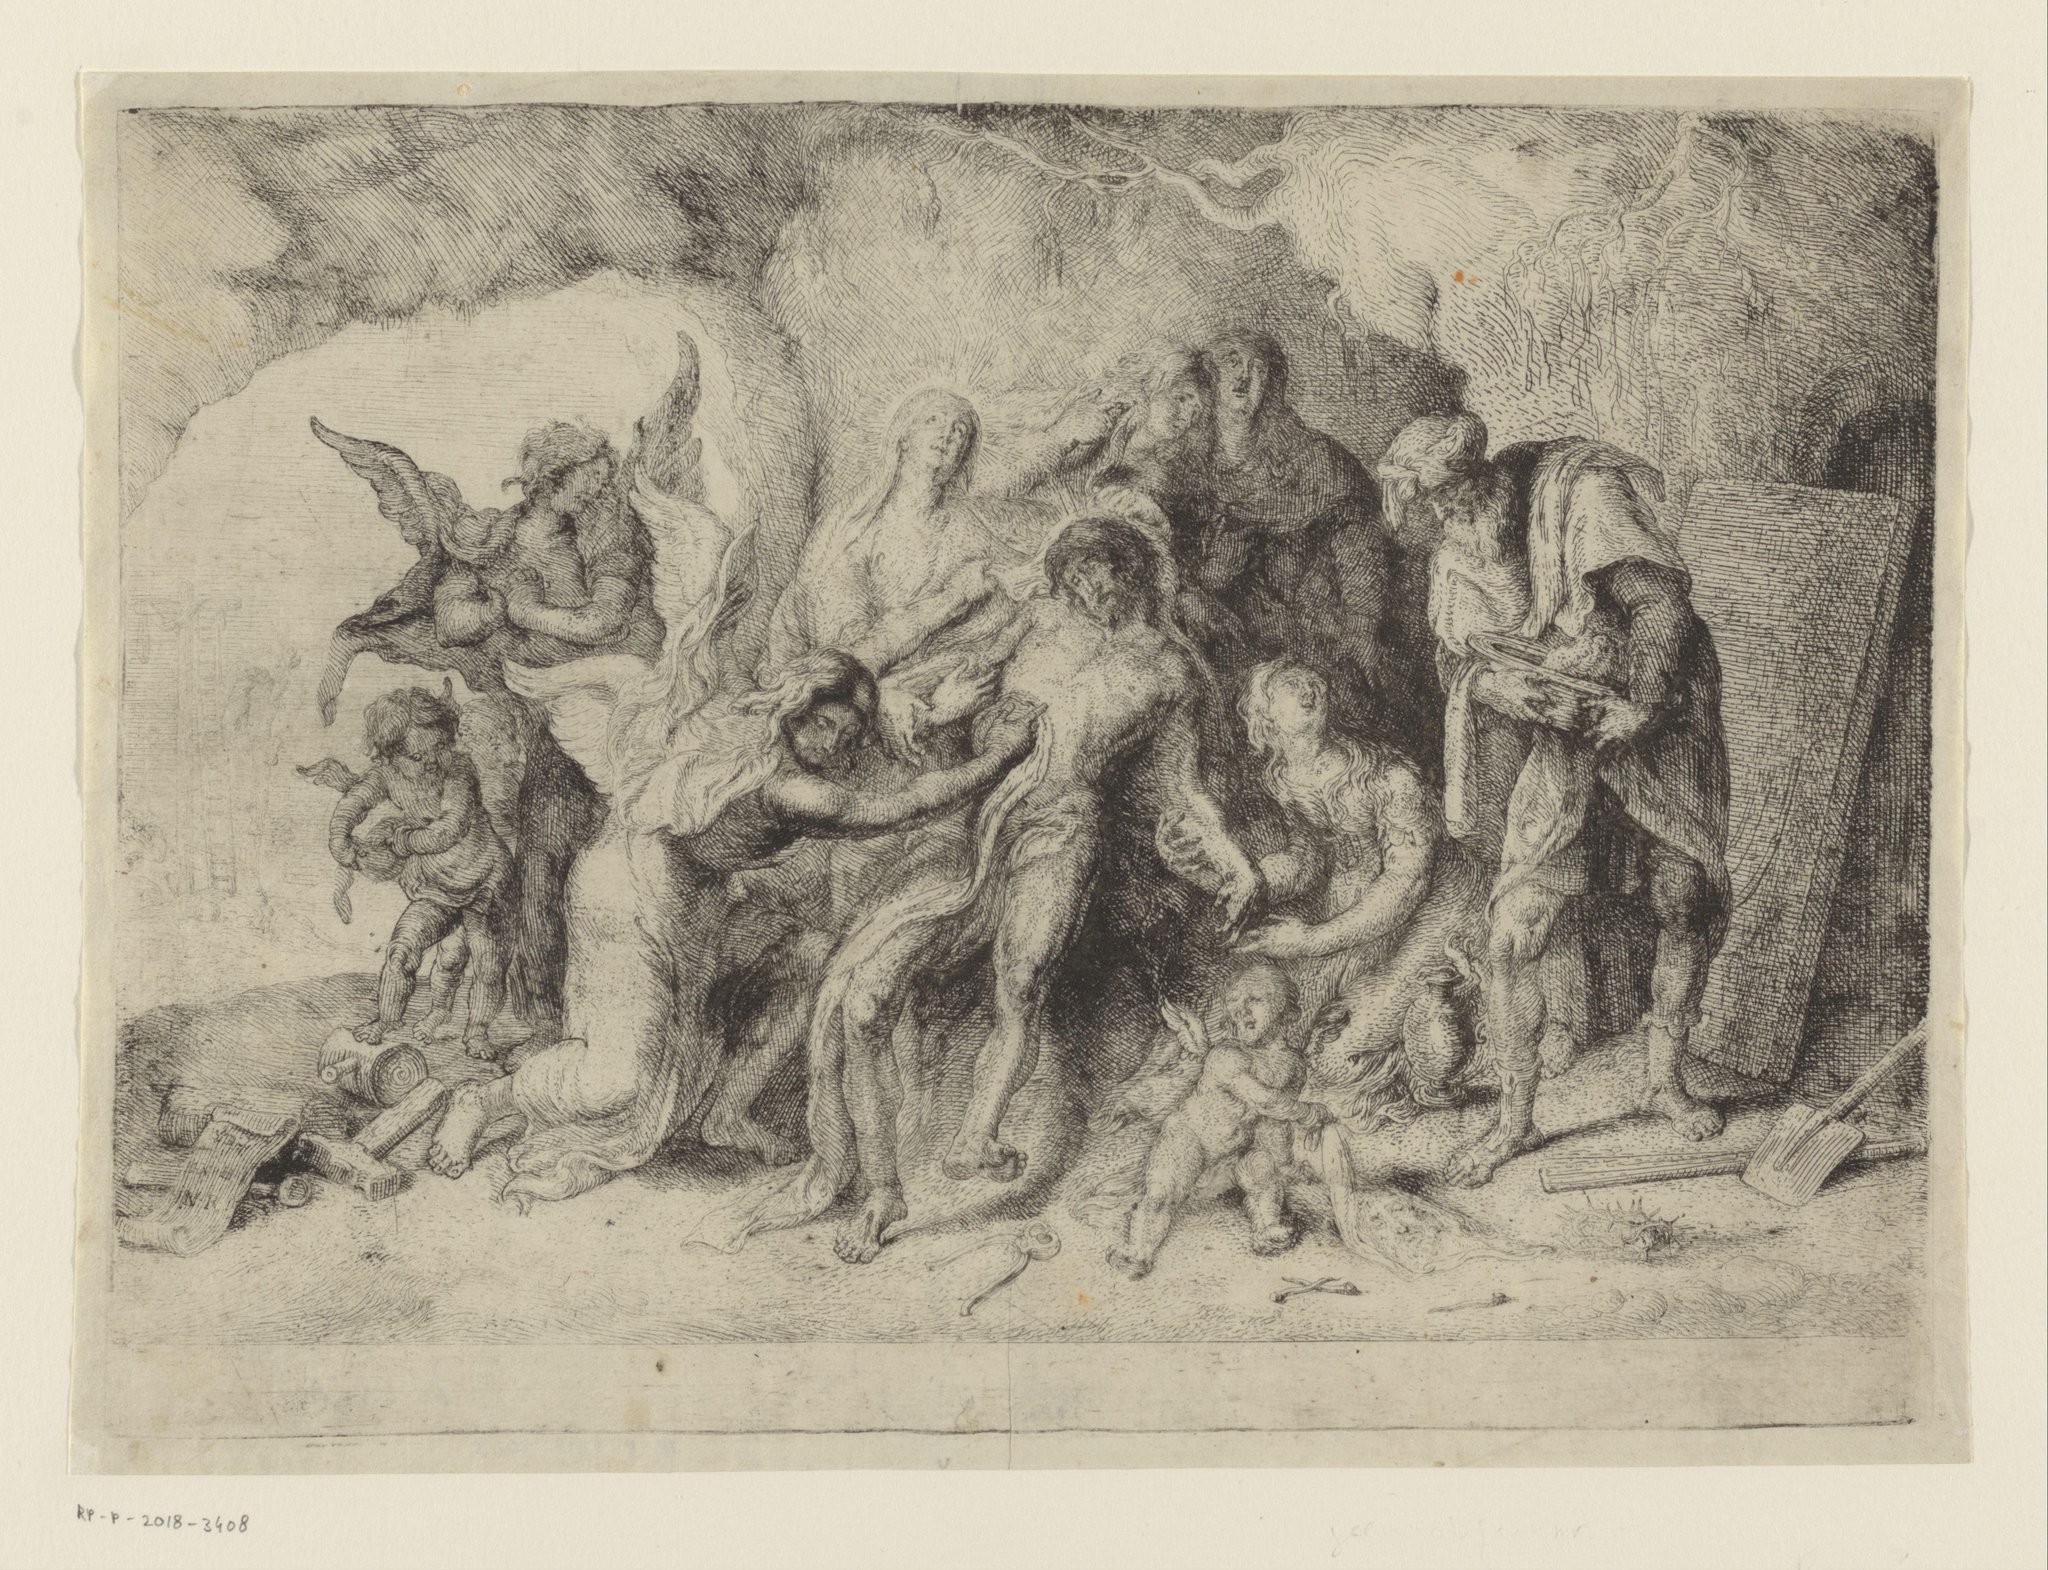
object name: print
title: Bewening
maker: Anonymous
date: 1600-1700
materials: paper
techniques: etching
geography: low countries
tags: preparations for christ's entombment, bearing of christ's body to the grave, lamentation over the dead christ by his relatives and friends (christ usually without crown of thorns)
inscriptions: watermark, collector's mark: Lugt 2228, collector's mark: ‘DOUBL./ R.P.K.’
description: De gestorven Christus wordt het graf ingedragen en beweend door onder andere engelen, Maria, Johannes en Maria Magdalena. Rechts staat een man met een schaal met spons in de handen. Op de grond liggen de passiewerktuigen: spijkers en doornenkroon. Een putto toont de Veronicadoek.